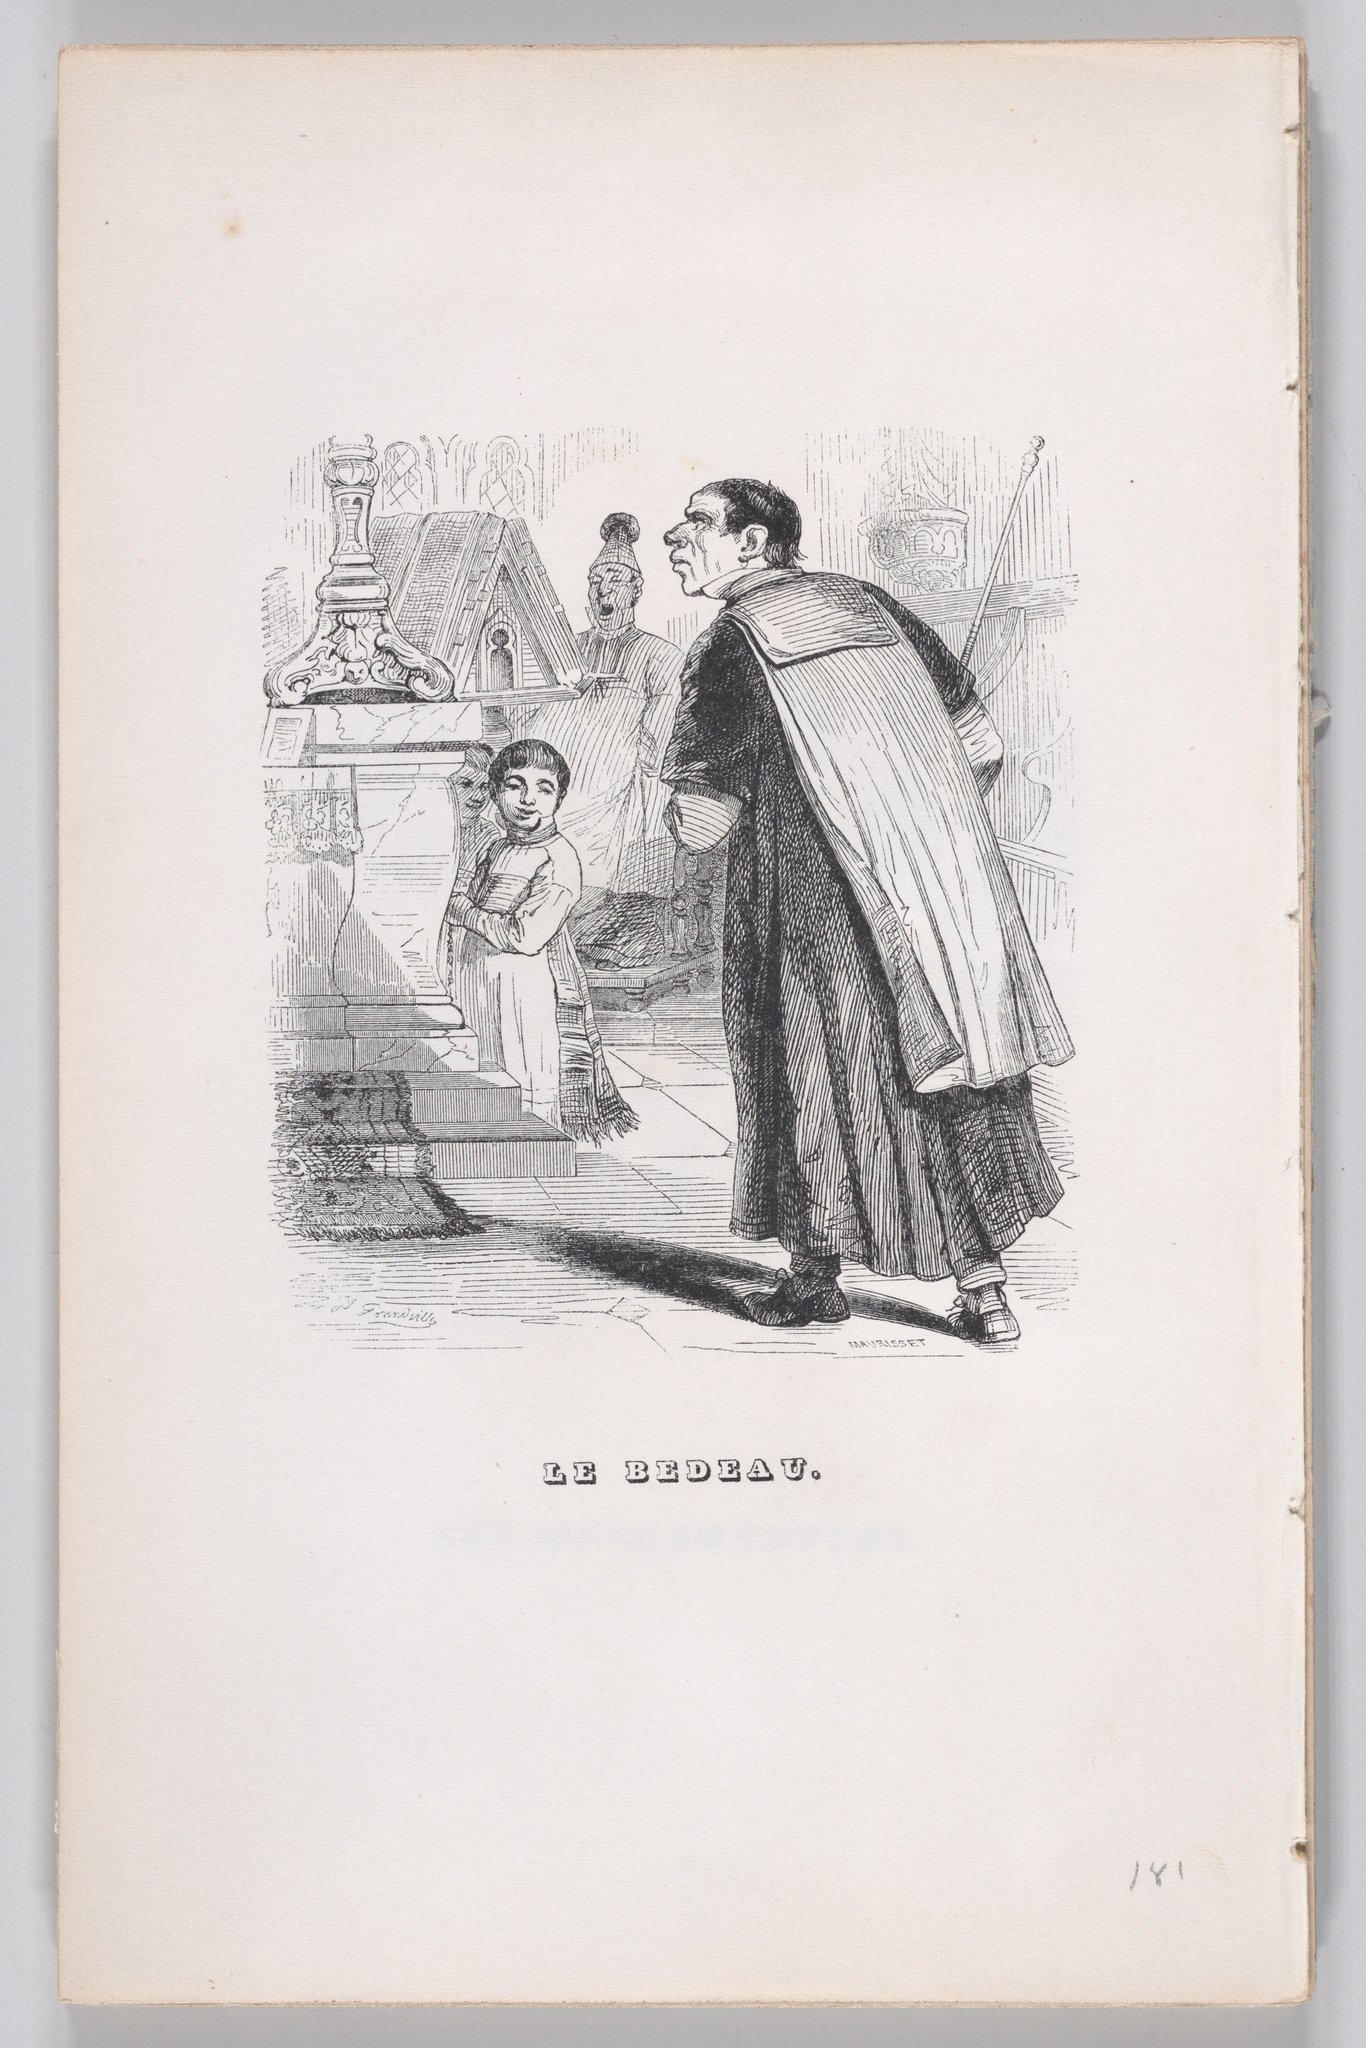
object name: print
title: The Beadle, from "The Complete Works of Béranger"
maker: j. j. grandville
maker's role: illustrator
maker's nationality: french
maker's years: 1803-1847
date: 1836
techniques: engraving